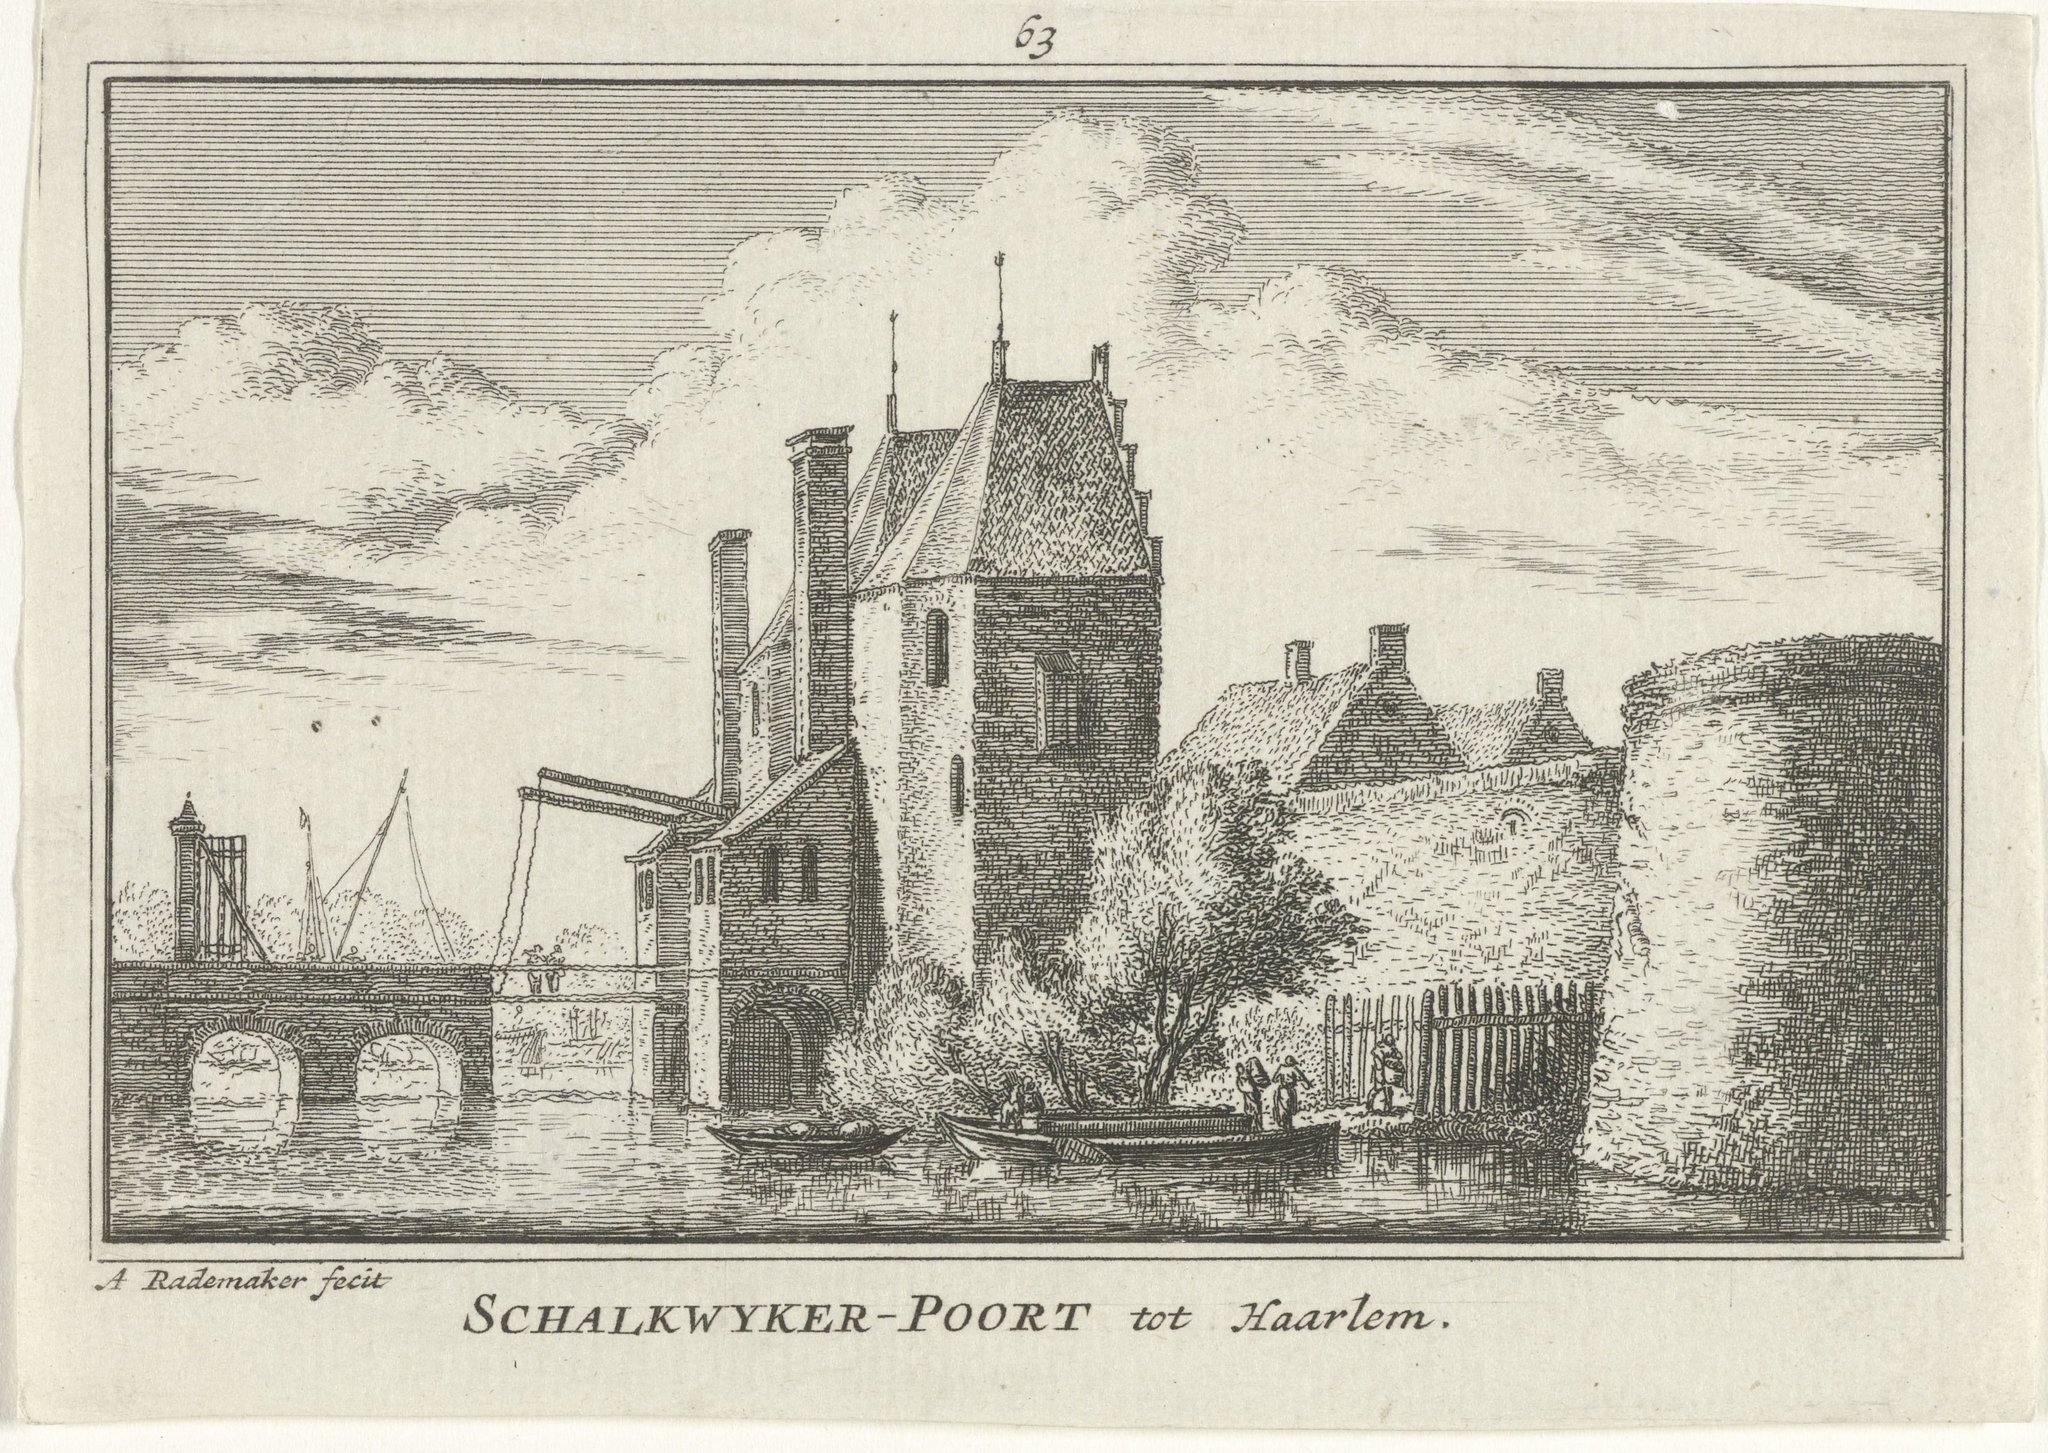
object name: book illustration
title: Schalkwyker-Poort tot Haarlem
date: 1727-1733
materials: paper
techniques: etching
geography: amsterdam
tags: rowing-boat, canoe, etc., bridge, city-gate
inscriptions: collector's mark: Lugt 2228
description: Illustratie uit: Abraham Rademaker, Matthaeus Brouërius van Niedek, Isaac Le Long, Kabinet van Nederlandsche en Kleefsche outheden en (...) voorname stads- en landgebouwen, Willem Barents en Antoni Schoonenburg: Amsterdam, 1727-1733, ill. nr. 63.